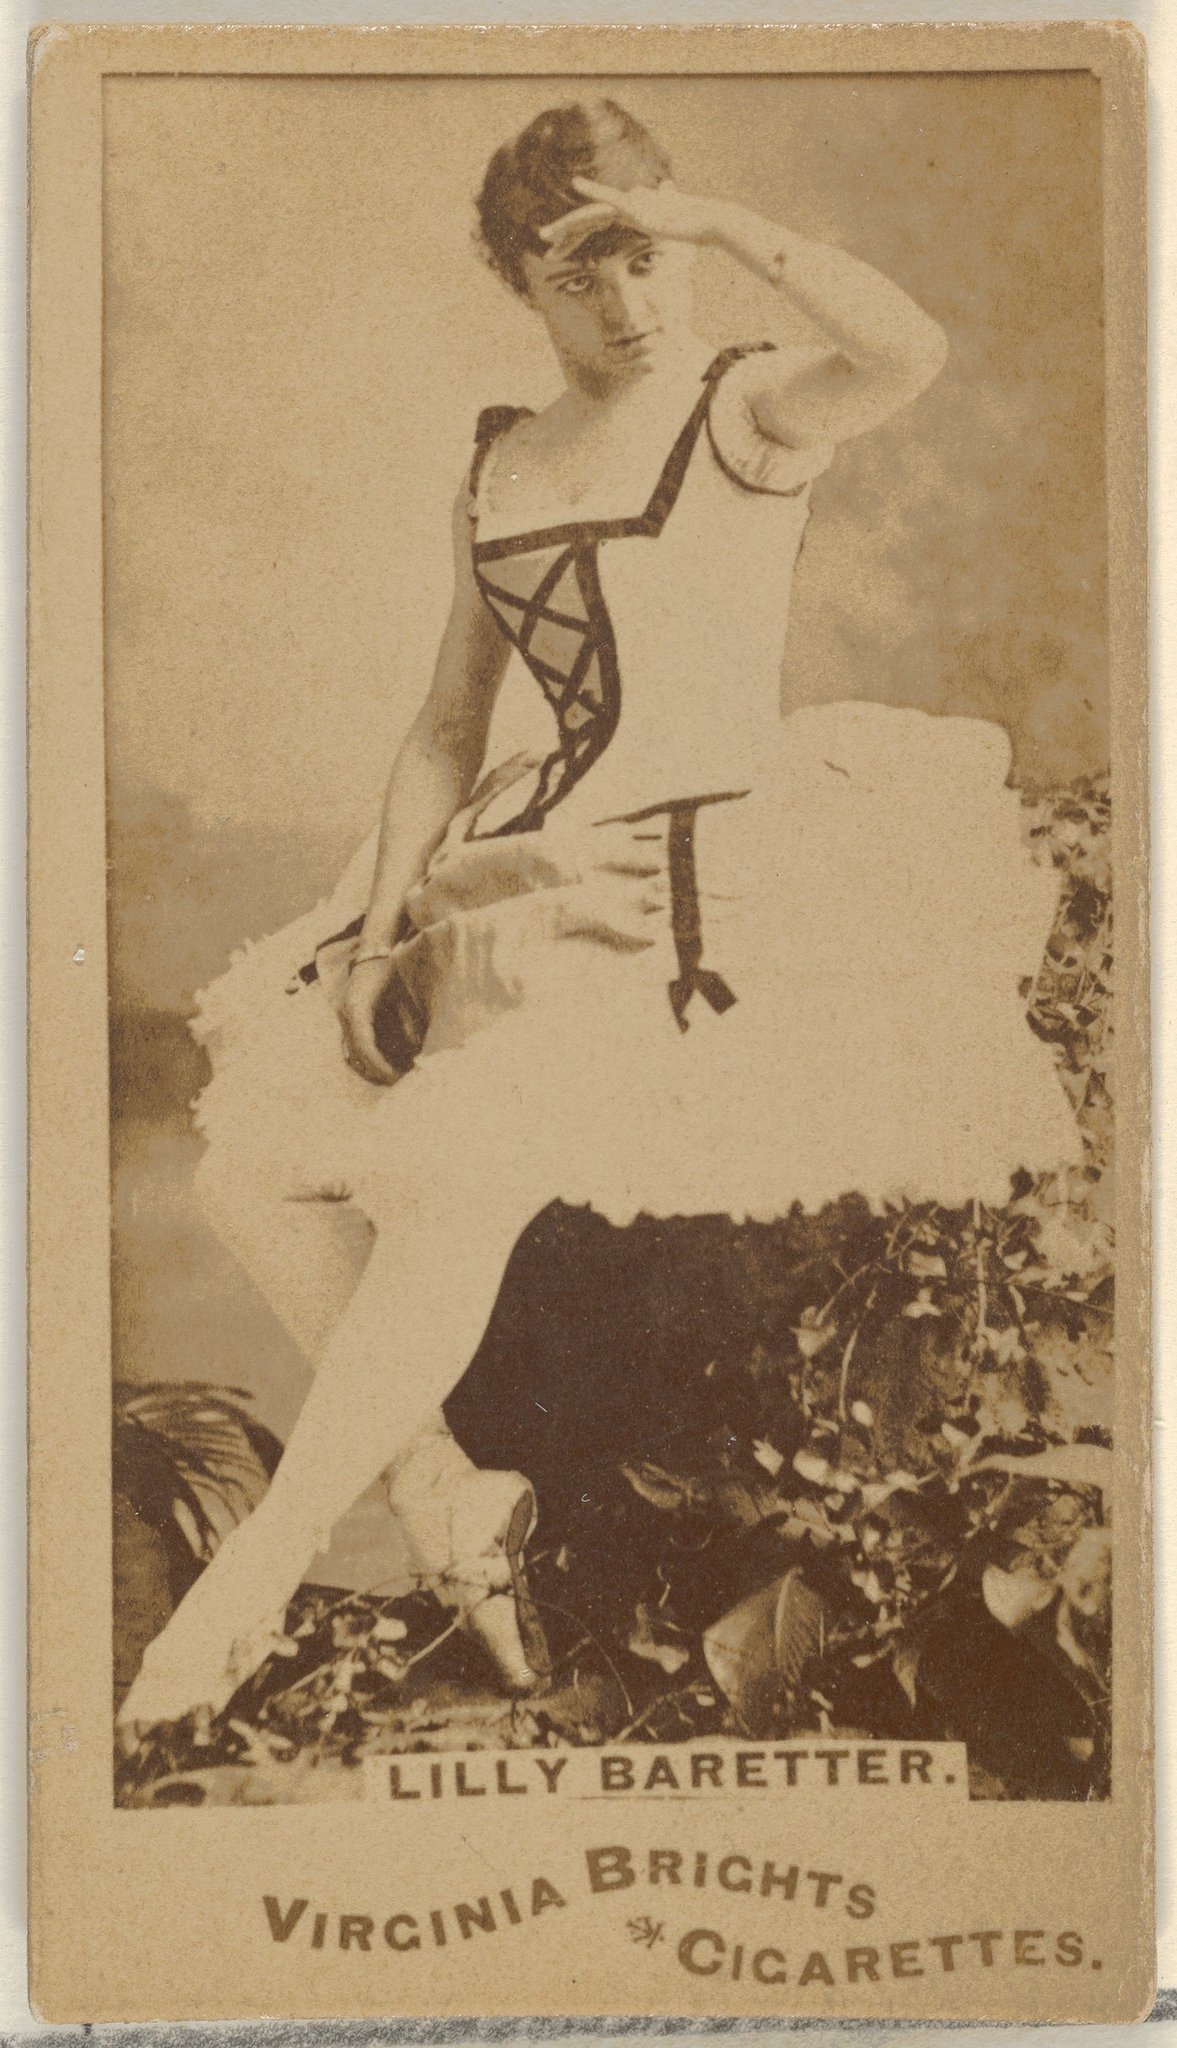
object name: photograph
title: Lilly Baretter, from the Actors and Actresses series (N45, Type 1) for Virginia Brights Cigarettes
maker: allen & ginter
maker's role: publisher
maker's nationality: american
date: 1888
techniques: albumen silver print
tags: portraits,women,actresses